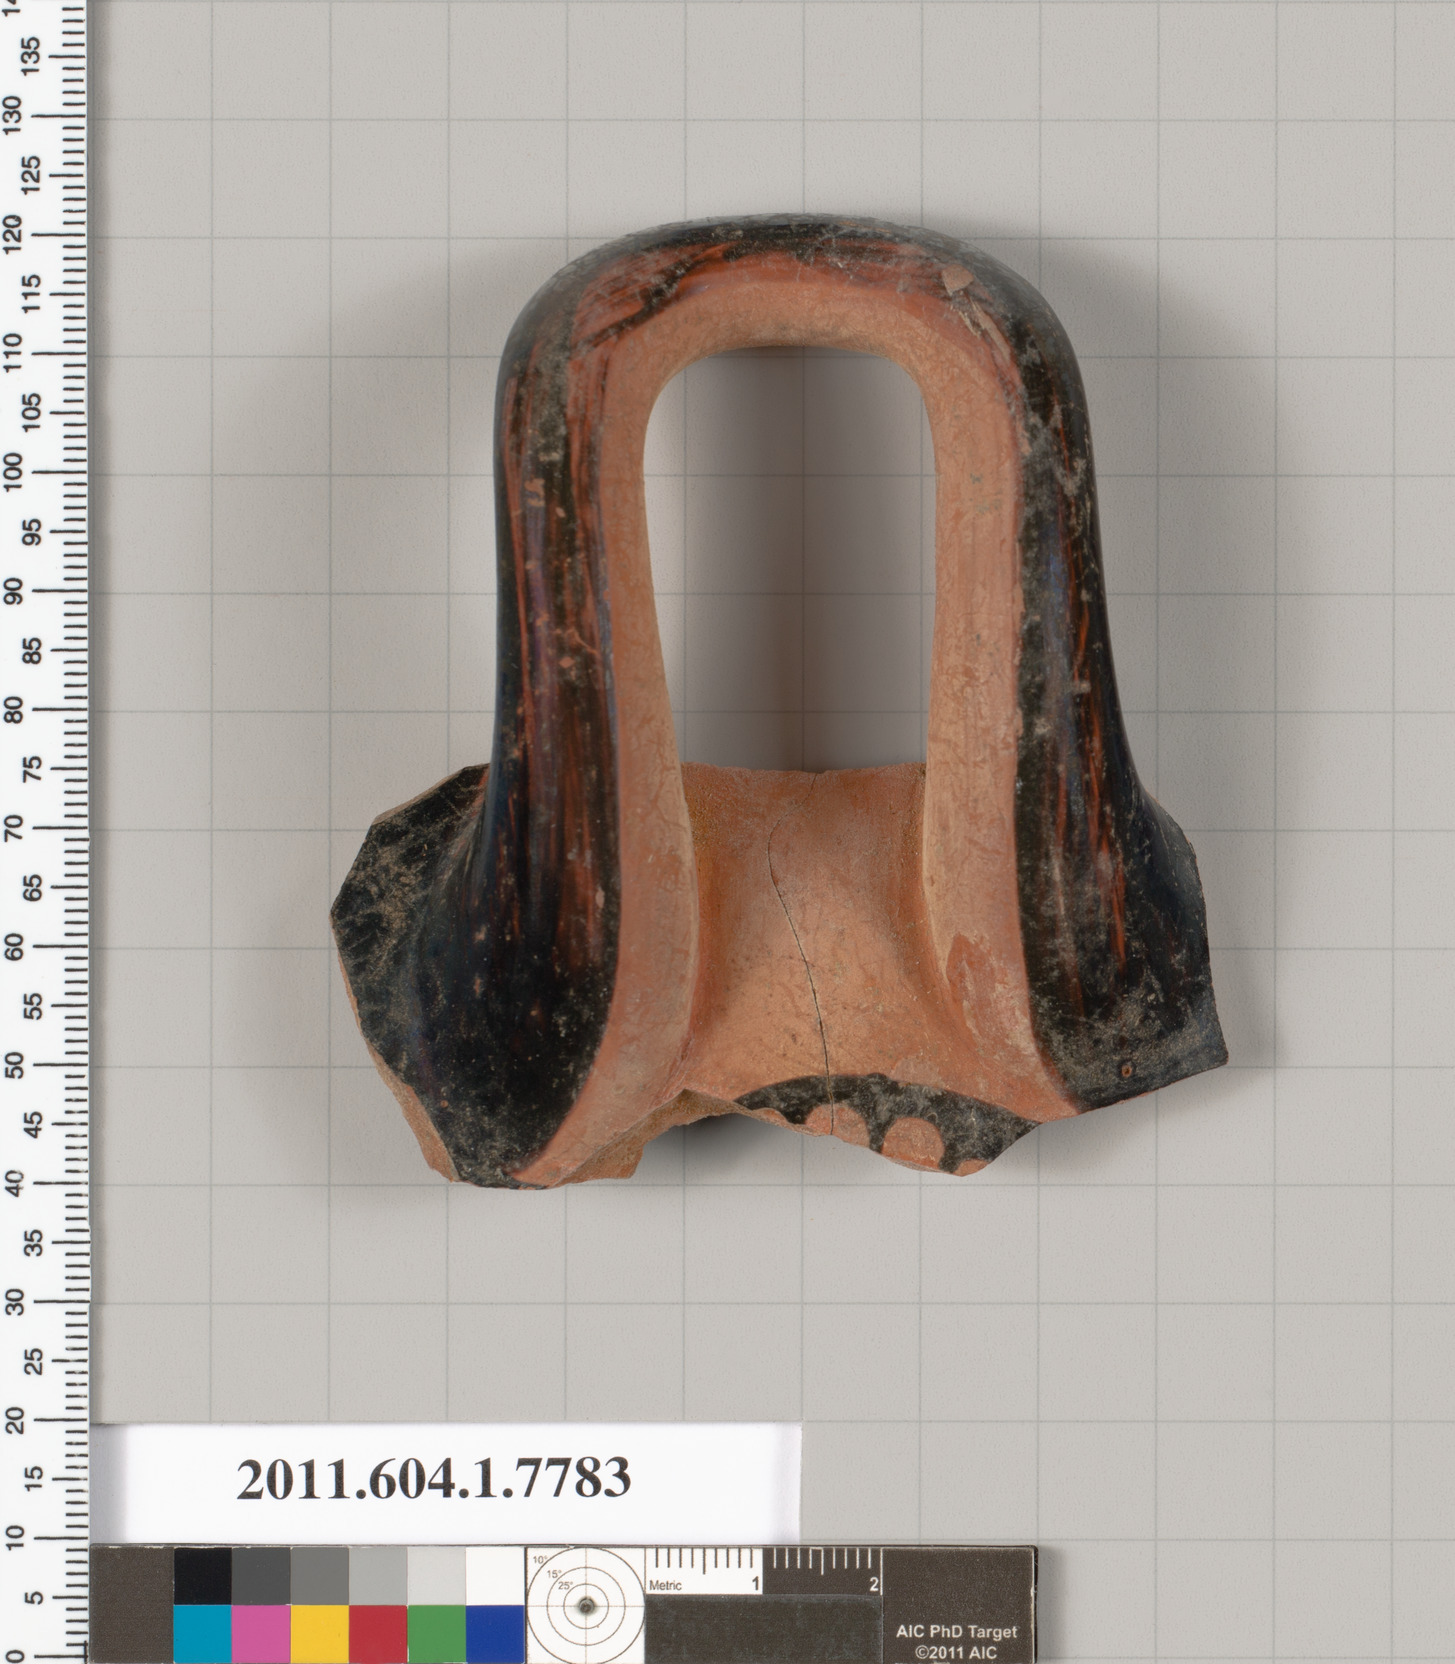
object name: kylix fragment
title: Terracotta fragment of a kylix (drinking cup)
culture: greek, attic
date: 460-450 BCE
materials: terracotta